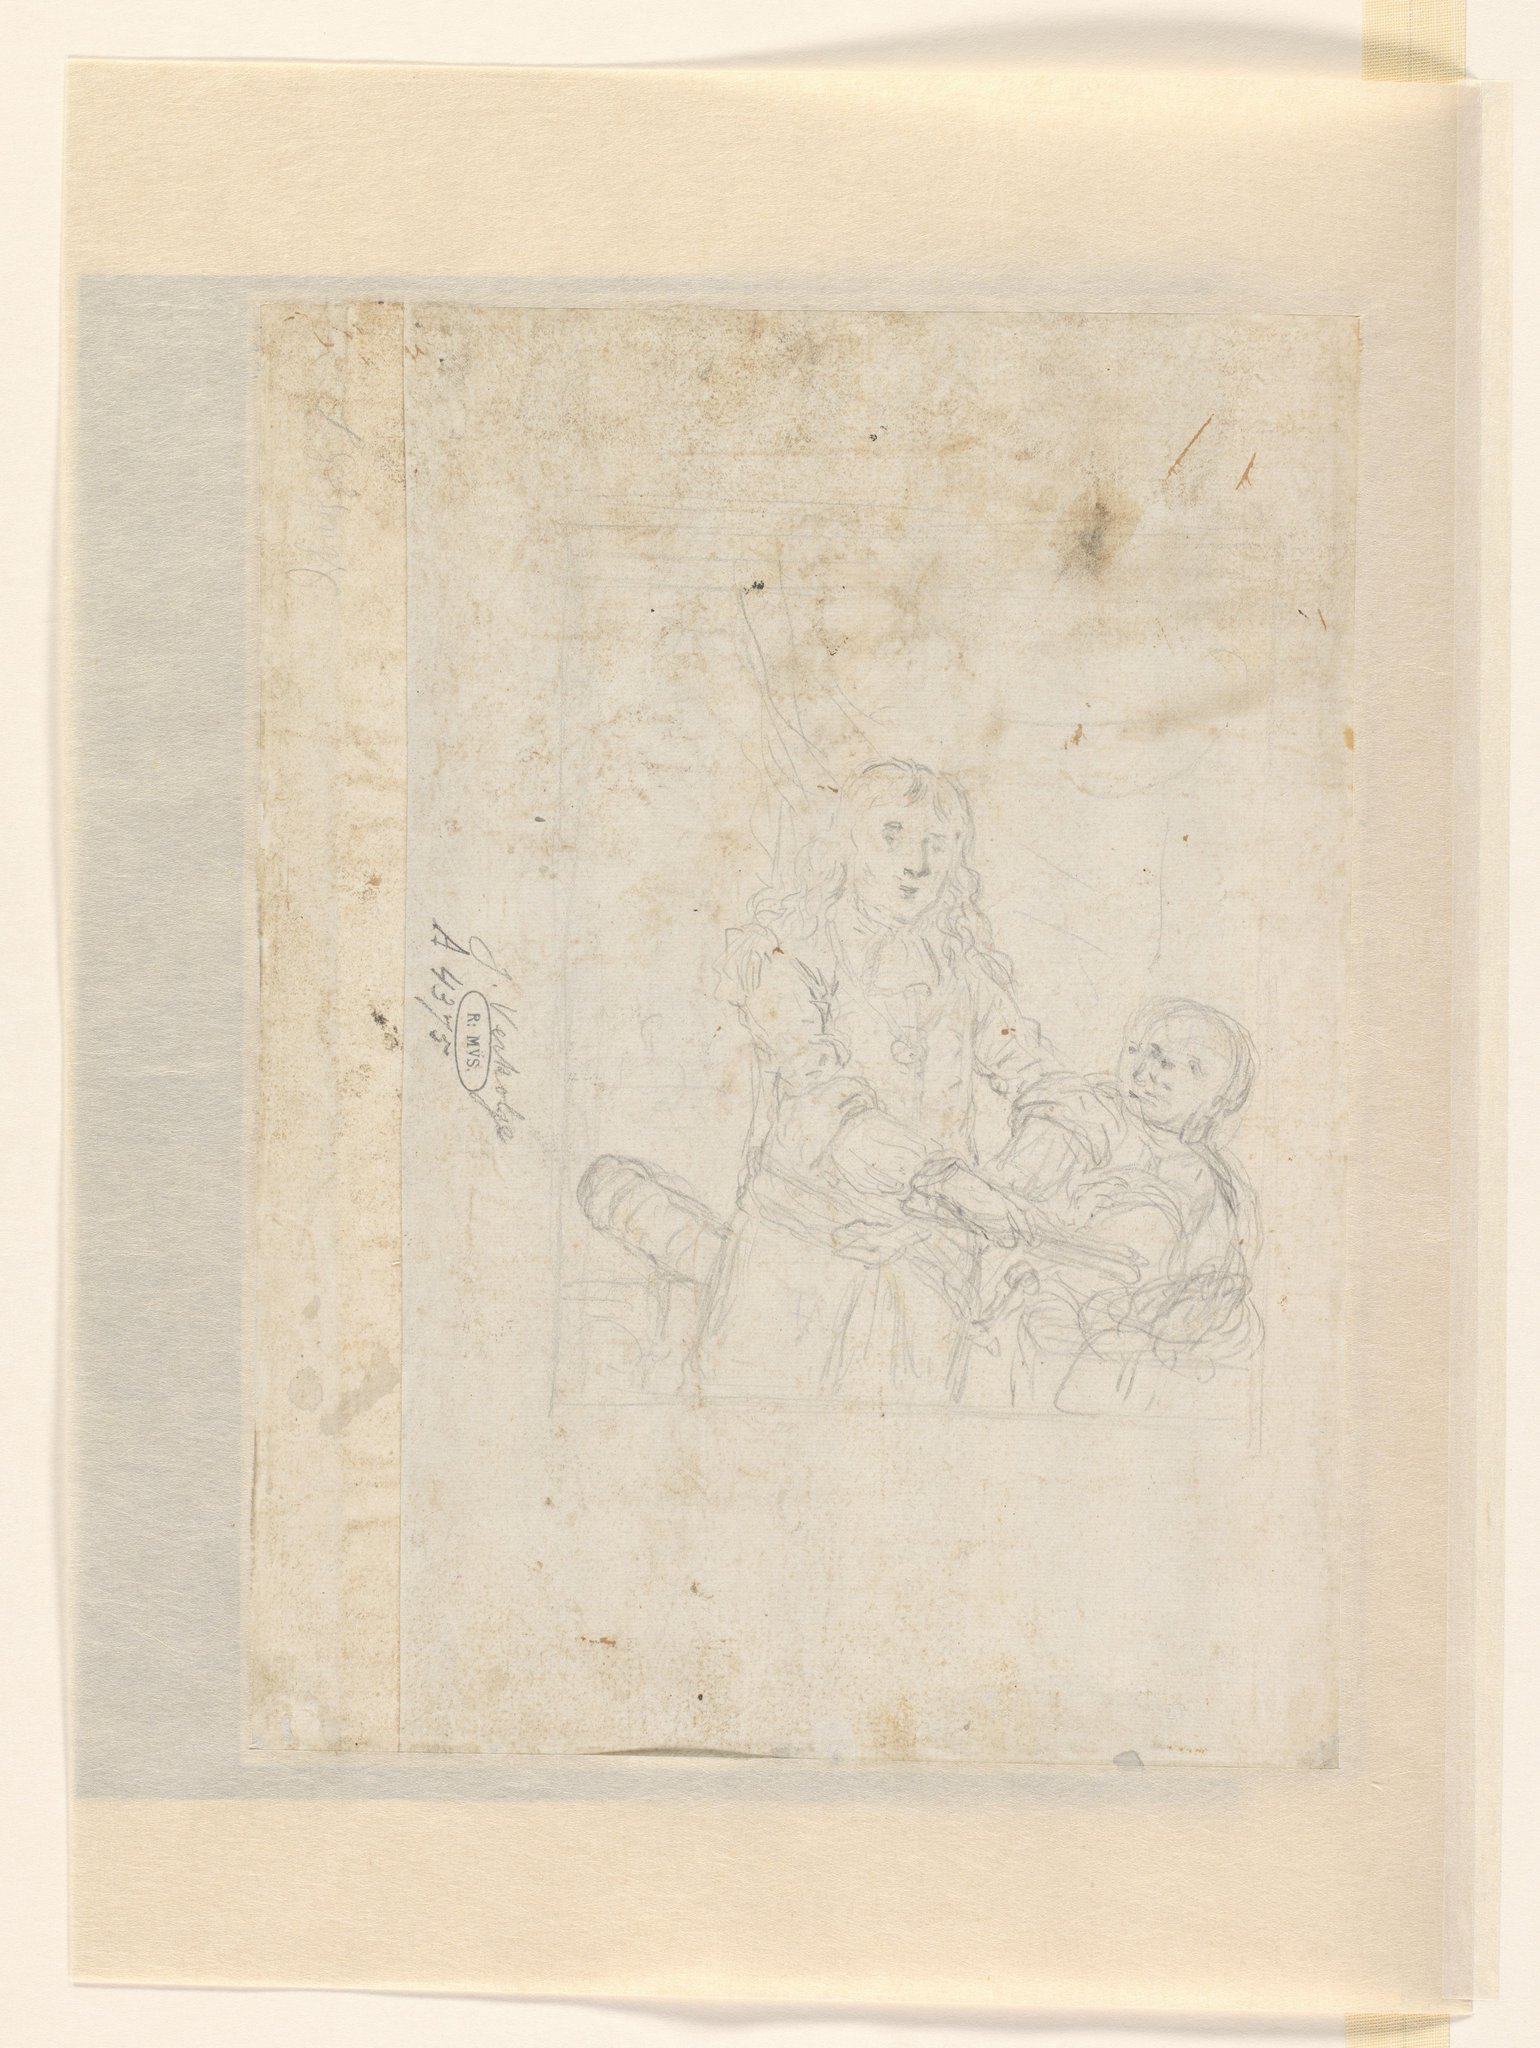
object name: drawing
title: Schets van een staande man met een meisje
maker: jan verkolje (i)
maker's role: draughtsman, painter, print maker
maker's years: 1650-1693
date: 1660-1693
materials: paper, pencil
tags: standing figure, girl (child between toddler and youth)